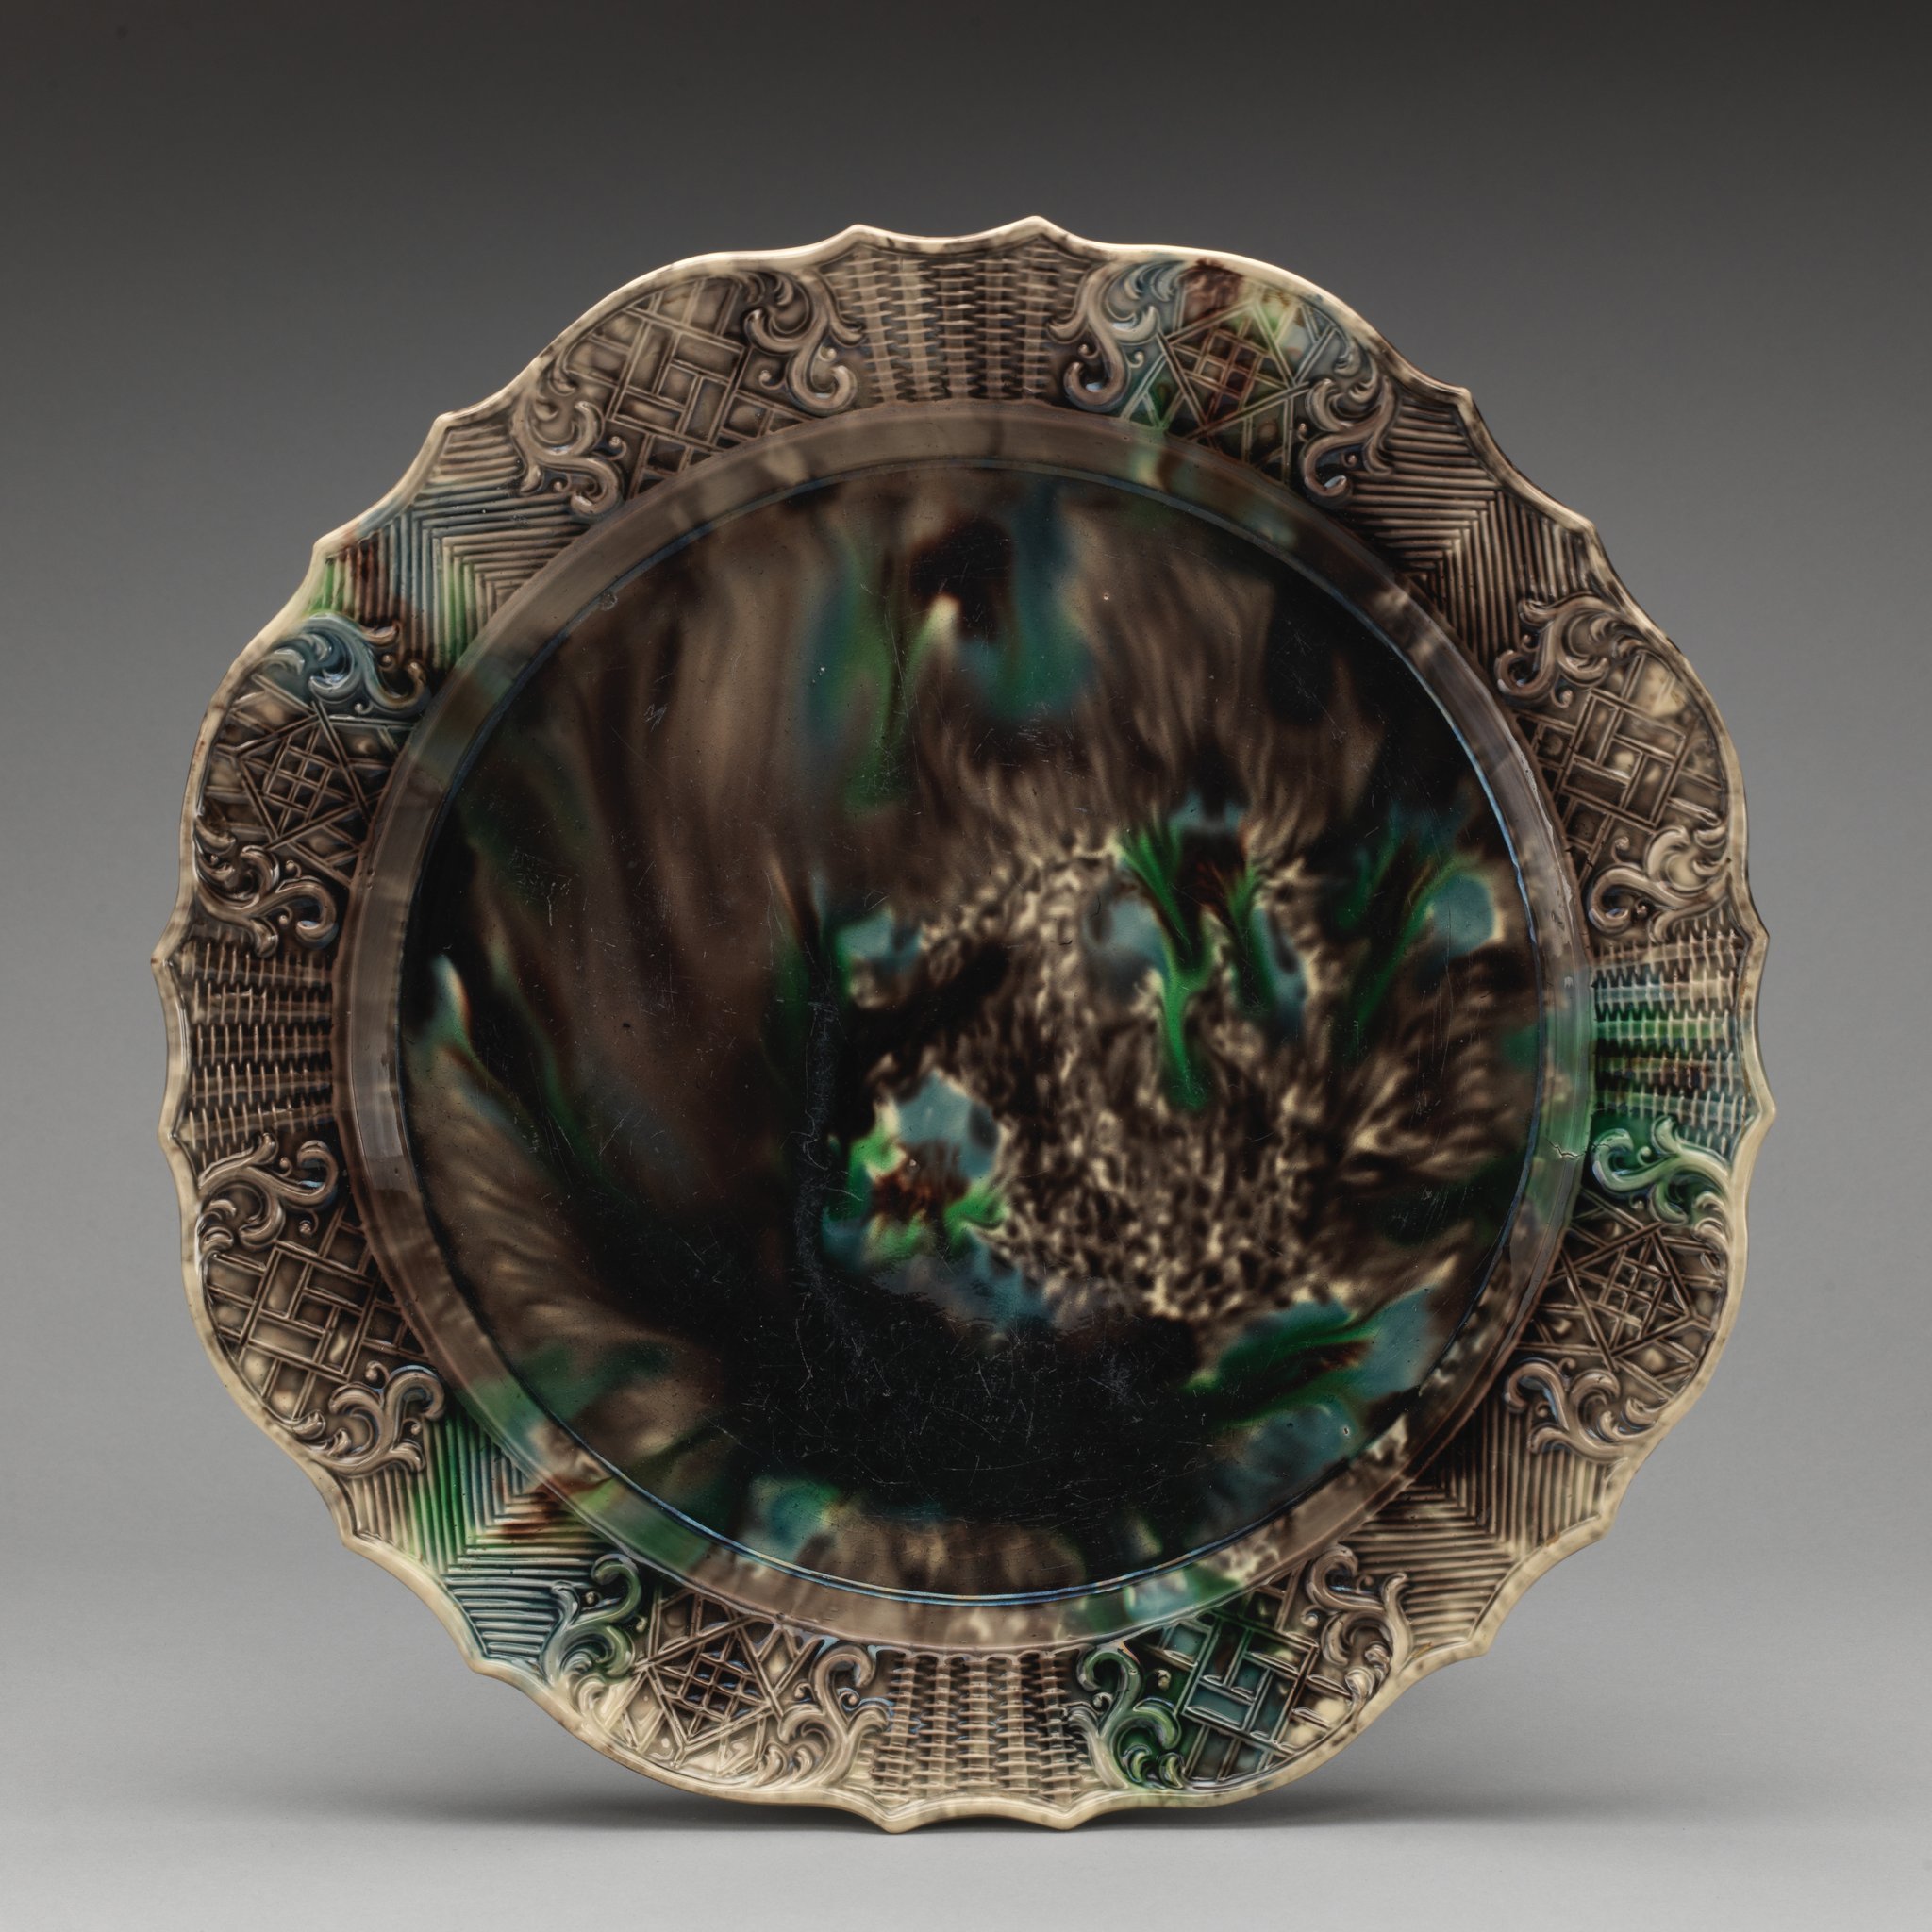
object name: dish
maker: whieldon type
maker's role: maker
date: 1760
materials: earthenware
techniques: glazing